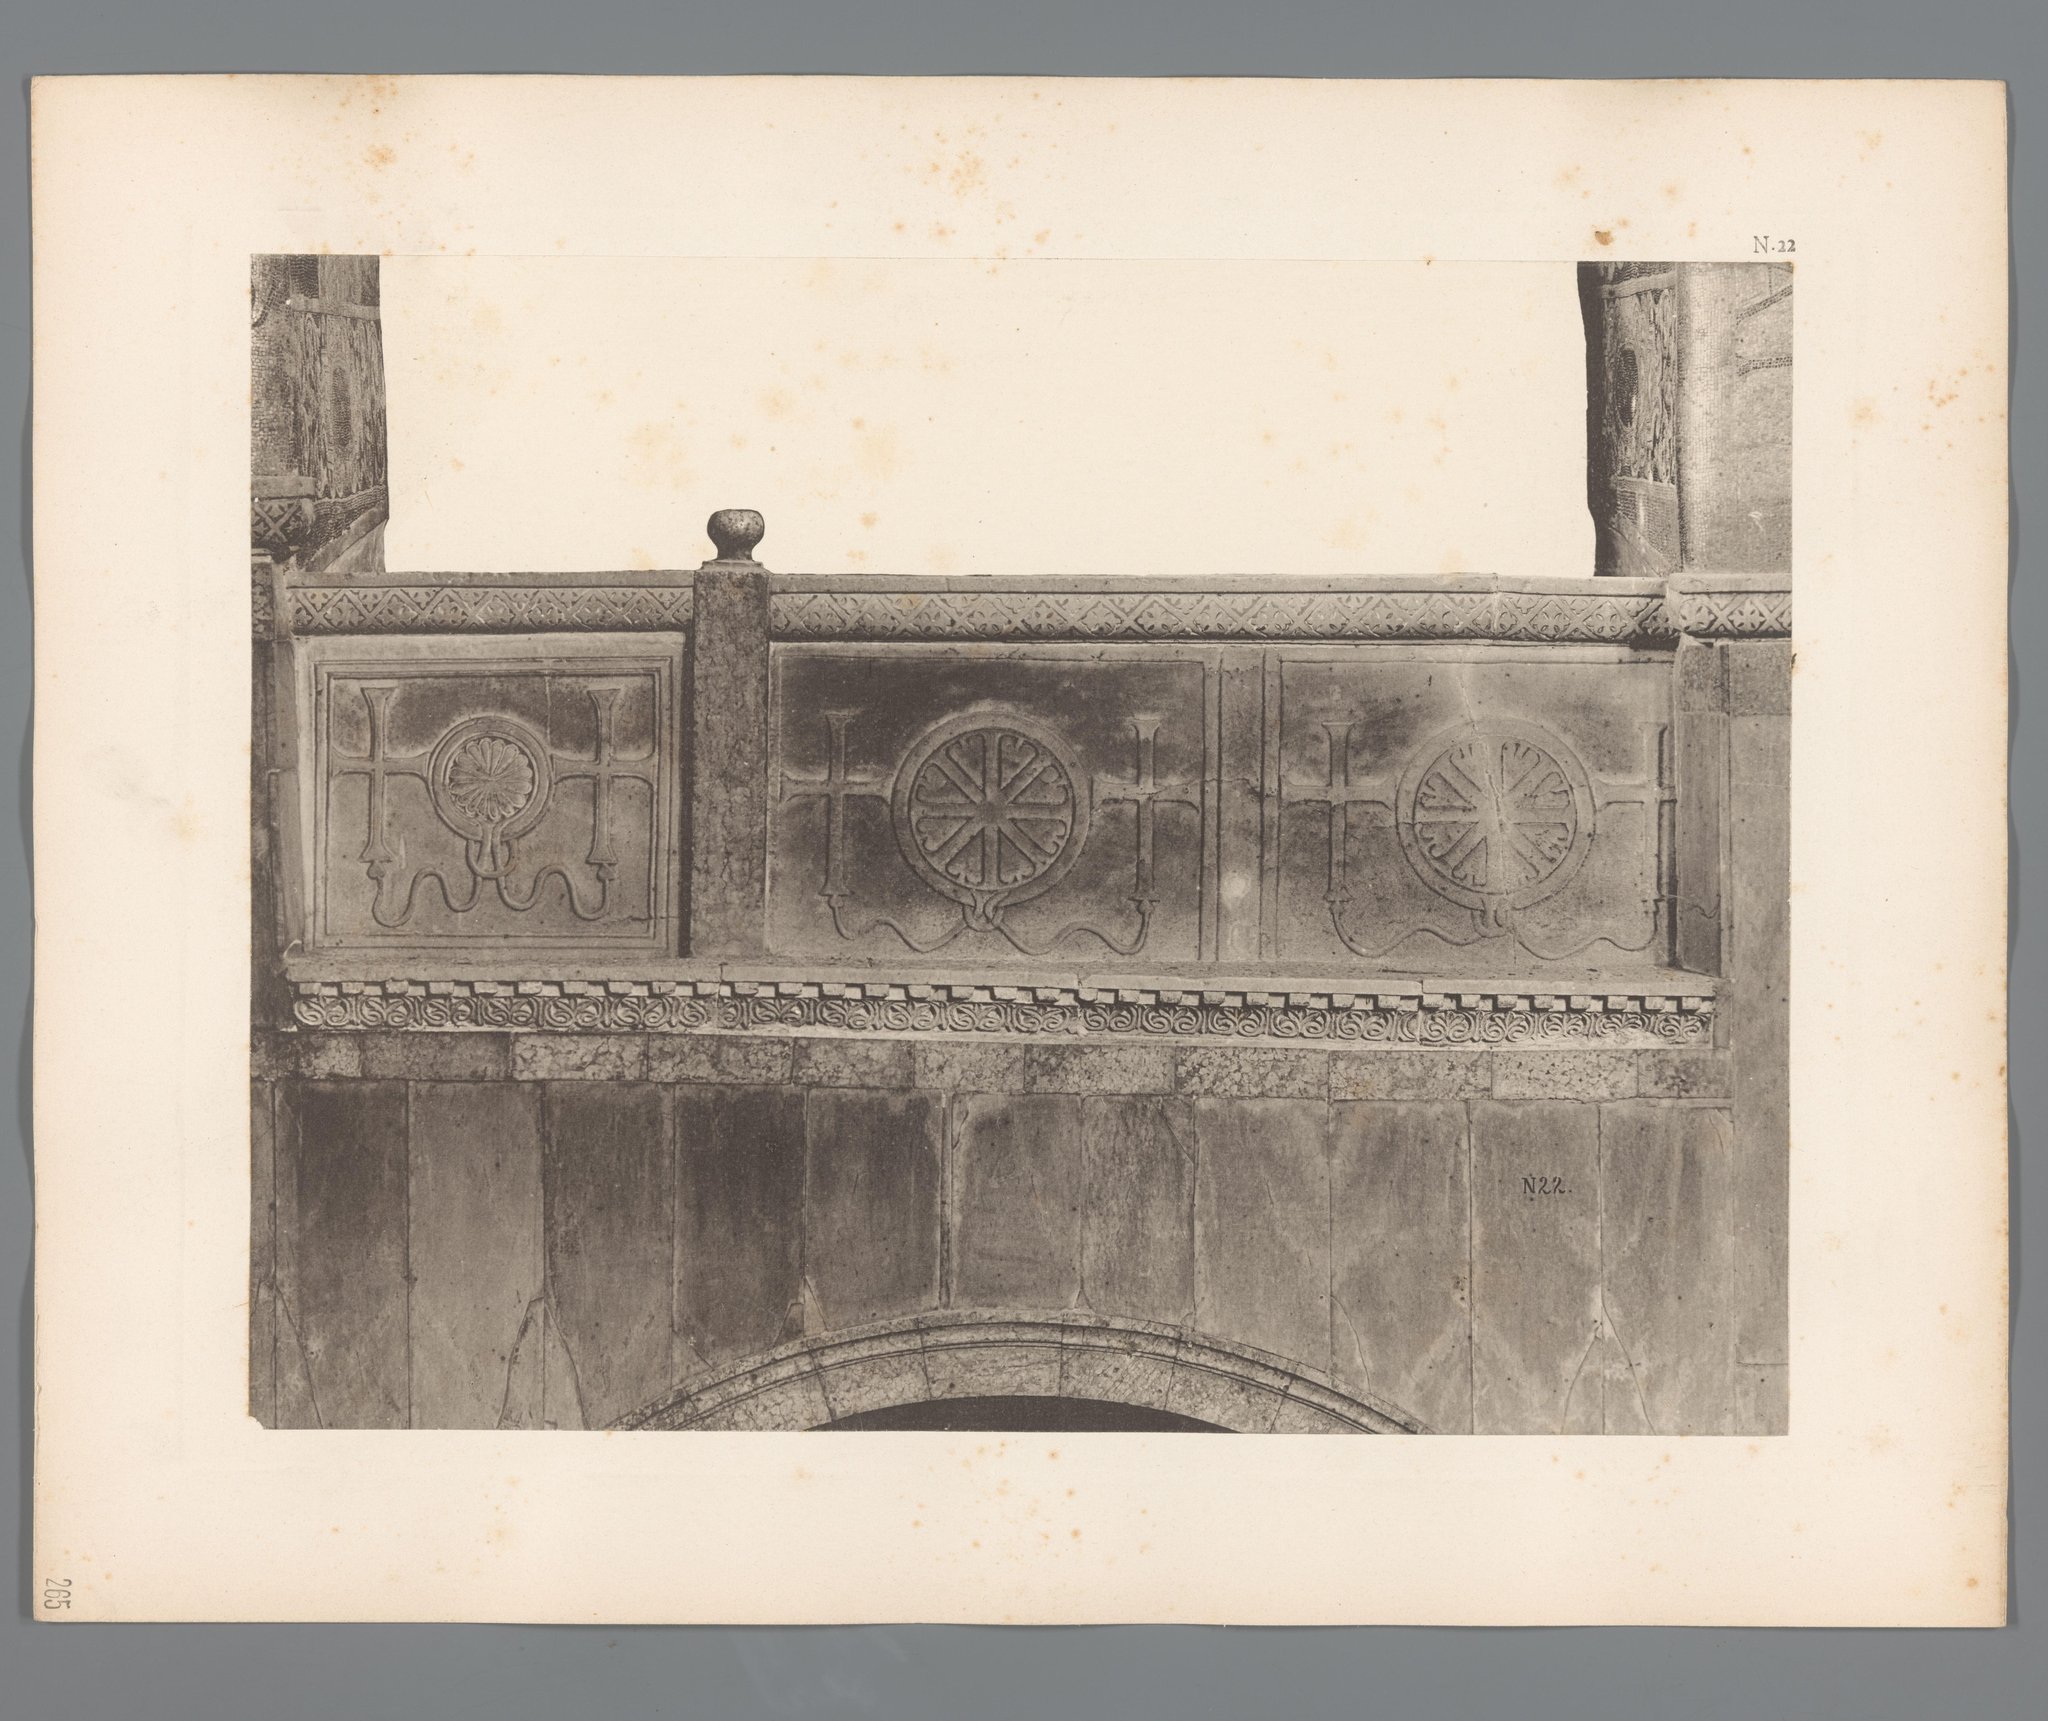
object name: photomechanical print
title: Balustrade met reliëf van de San Marco in Venetië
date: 1880-1885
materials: paper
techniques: photograph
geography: venice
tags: balustrade, piece of sculpture, reproduction of a piece of sculpture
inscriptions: number: ‘N.22’, number: ‘265’, number: ‘N.22.’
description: Deze prent maakt deel uit van een omslag met 58 prenten op 50 bladen.